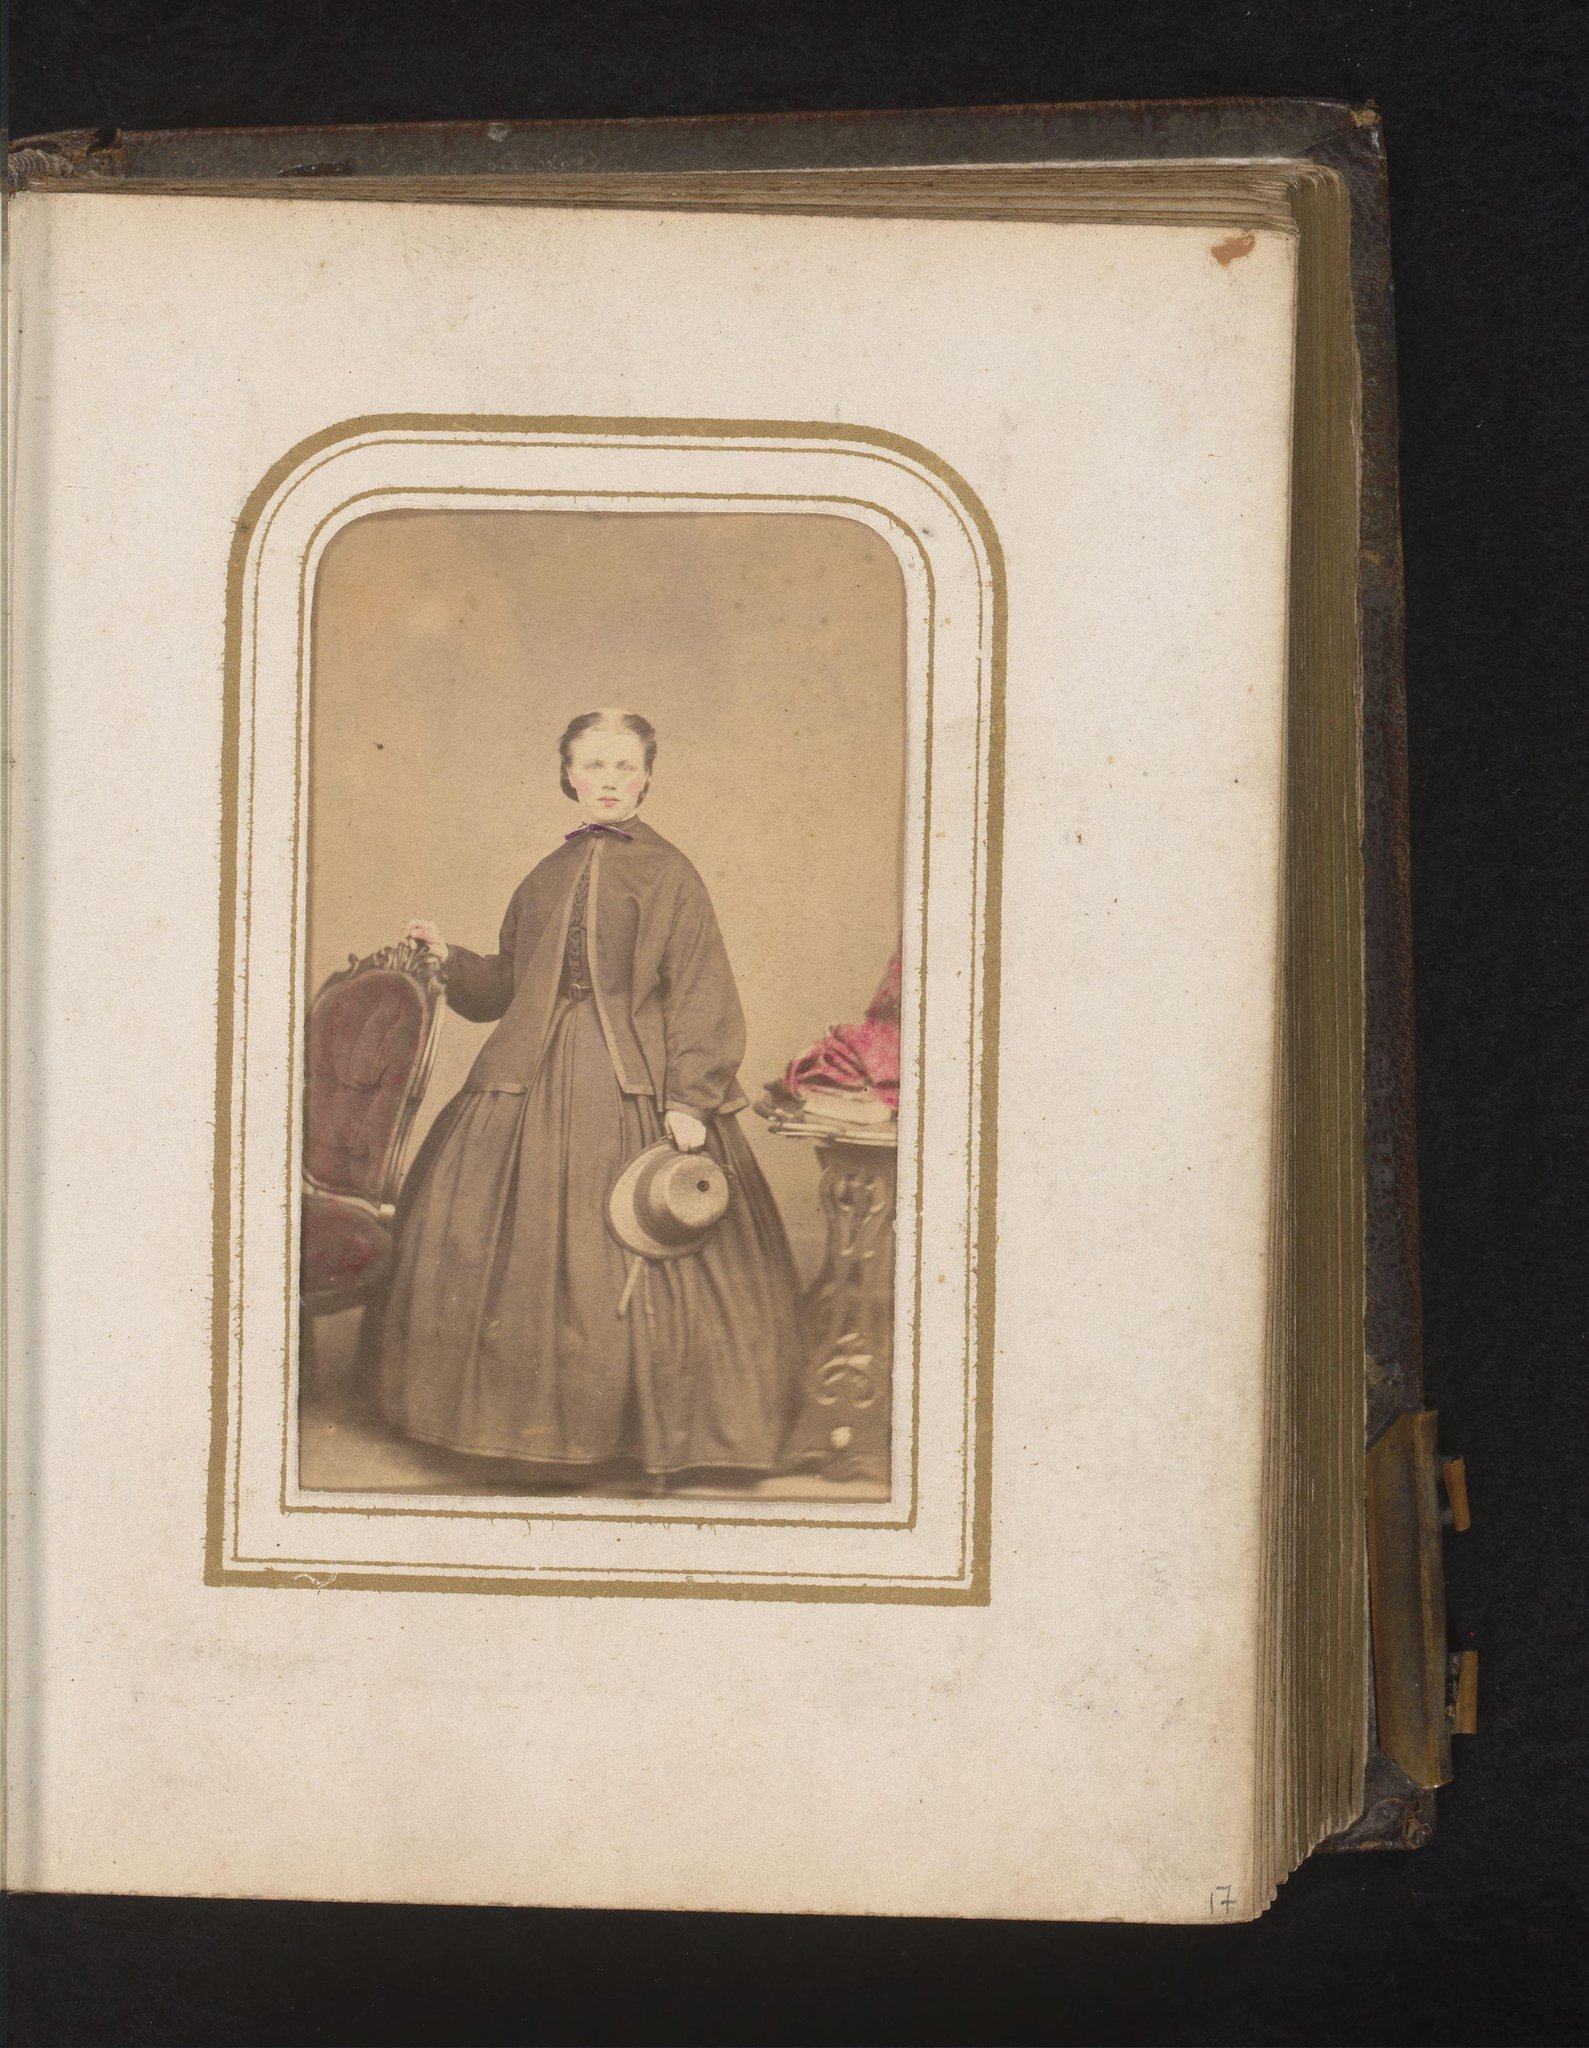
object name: carte de visite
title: Portret van een vrouw met hoed in de hand, staand bij een stoel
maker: william peter truefitt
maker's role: fotograaf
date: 1860-1880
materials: cardboard, photographic support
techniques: albumen print, hand coloring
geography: edinburgh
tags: historical persons - bb - woman, head-gear: hat, standing figure - aa - female human figure, chair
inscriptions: inscription: ‘W. TRUEFITT/ 65 PRINCES St EDINb’